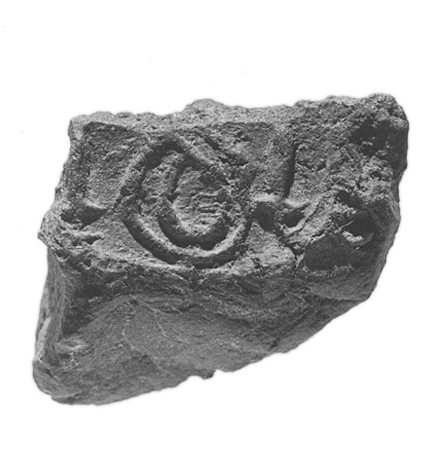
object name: sealing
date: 2030-1640 BCE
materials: clay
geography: egypt